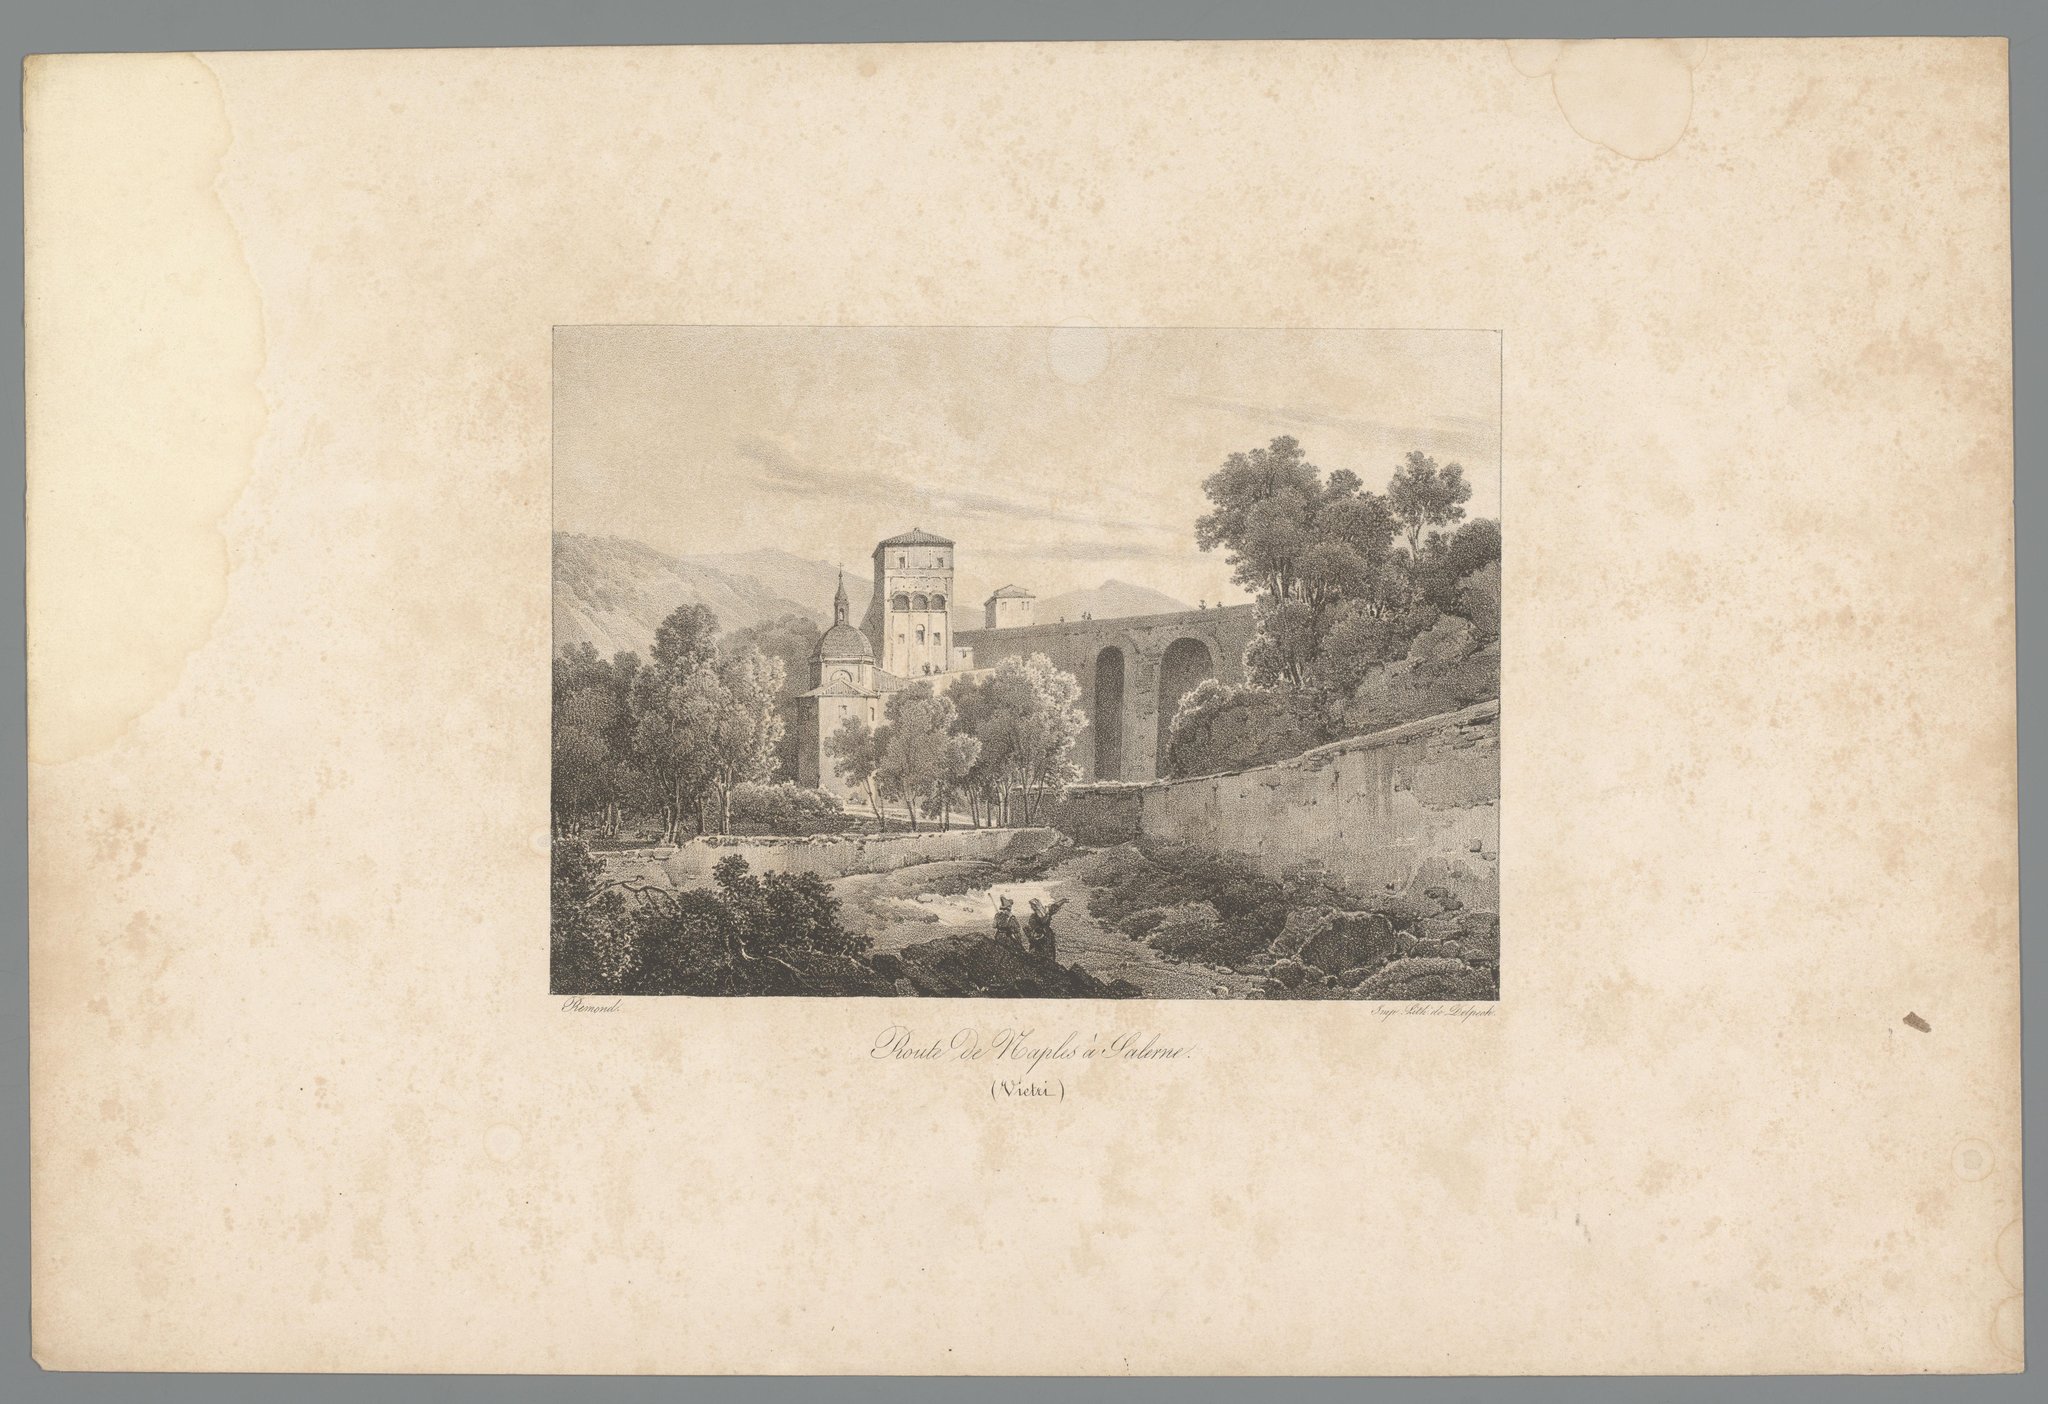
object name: print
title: Route de Naples à Salerne. (Vietri)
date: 1827-1828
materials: paper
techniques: lithograph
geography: paris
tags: prospect of village, silhouette of village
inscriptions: collector's mark: Lugt 2228